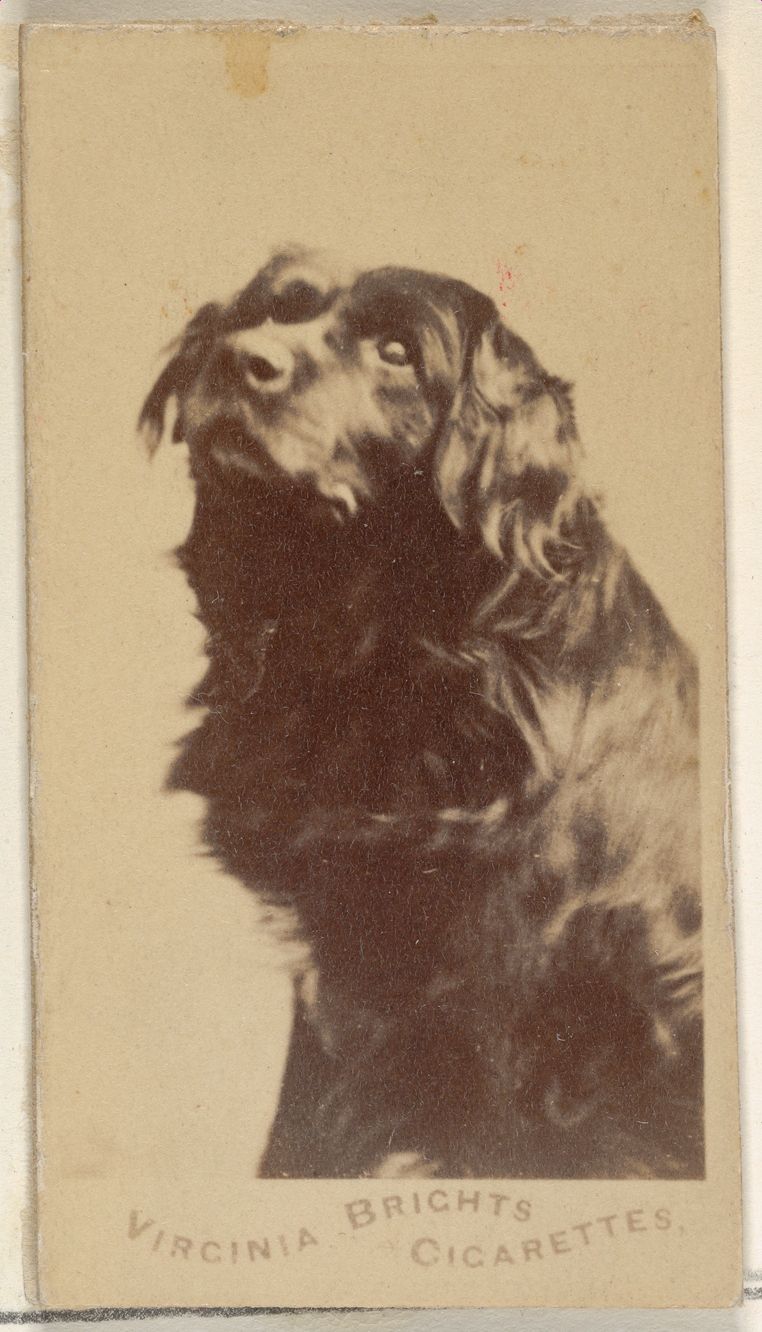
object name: photograph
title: From the Dogs series (N47) for Virginia Brights Cigarettes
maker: allen & ginter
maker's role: publisher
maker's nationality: american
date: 1888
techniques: albumen silver print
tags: dogs